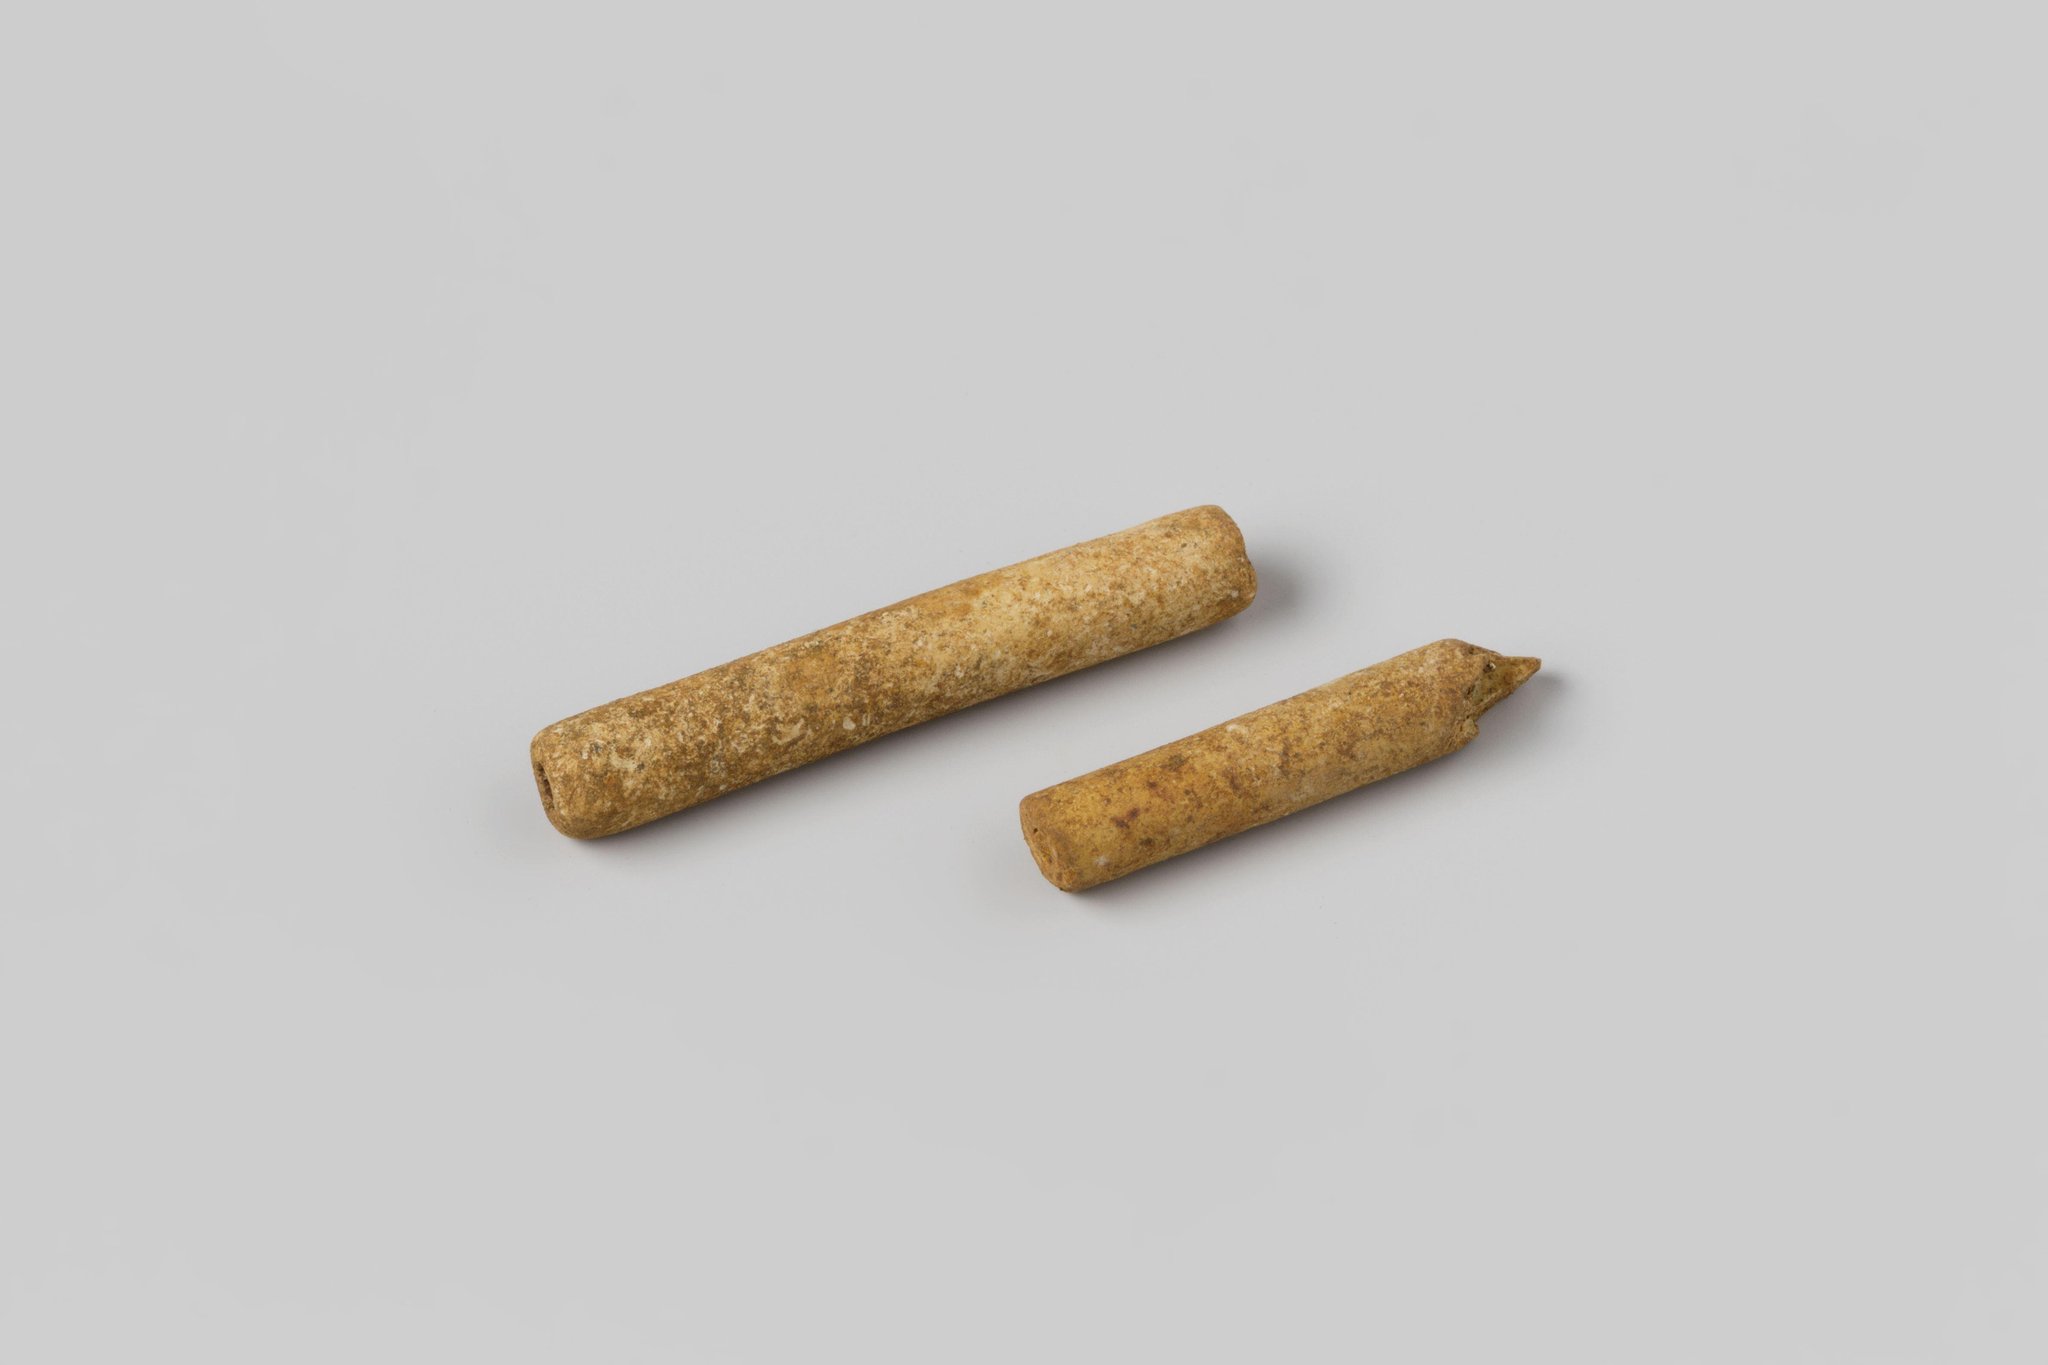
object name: pipe stem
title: Fragmenten pijpenstelen uit het wrak van de Oost-Indiëvaarder Hollandia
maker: Anonymous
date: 1700-1743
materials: clay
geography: netherlands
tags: verenigde oostindische compagnie, hollandia (schip), annet